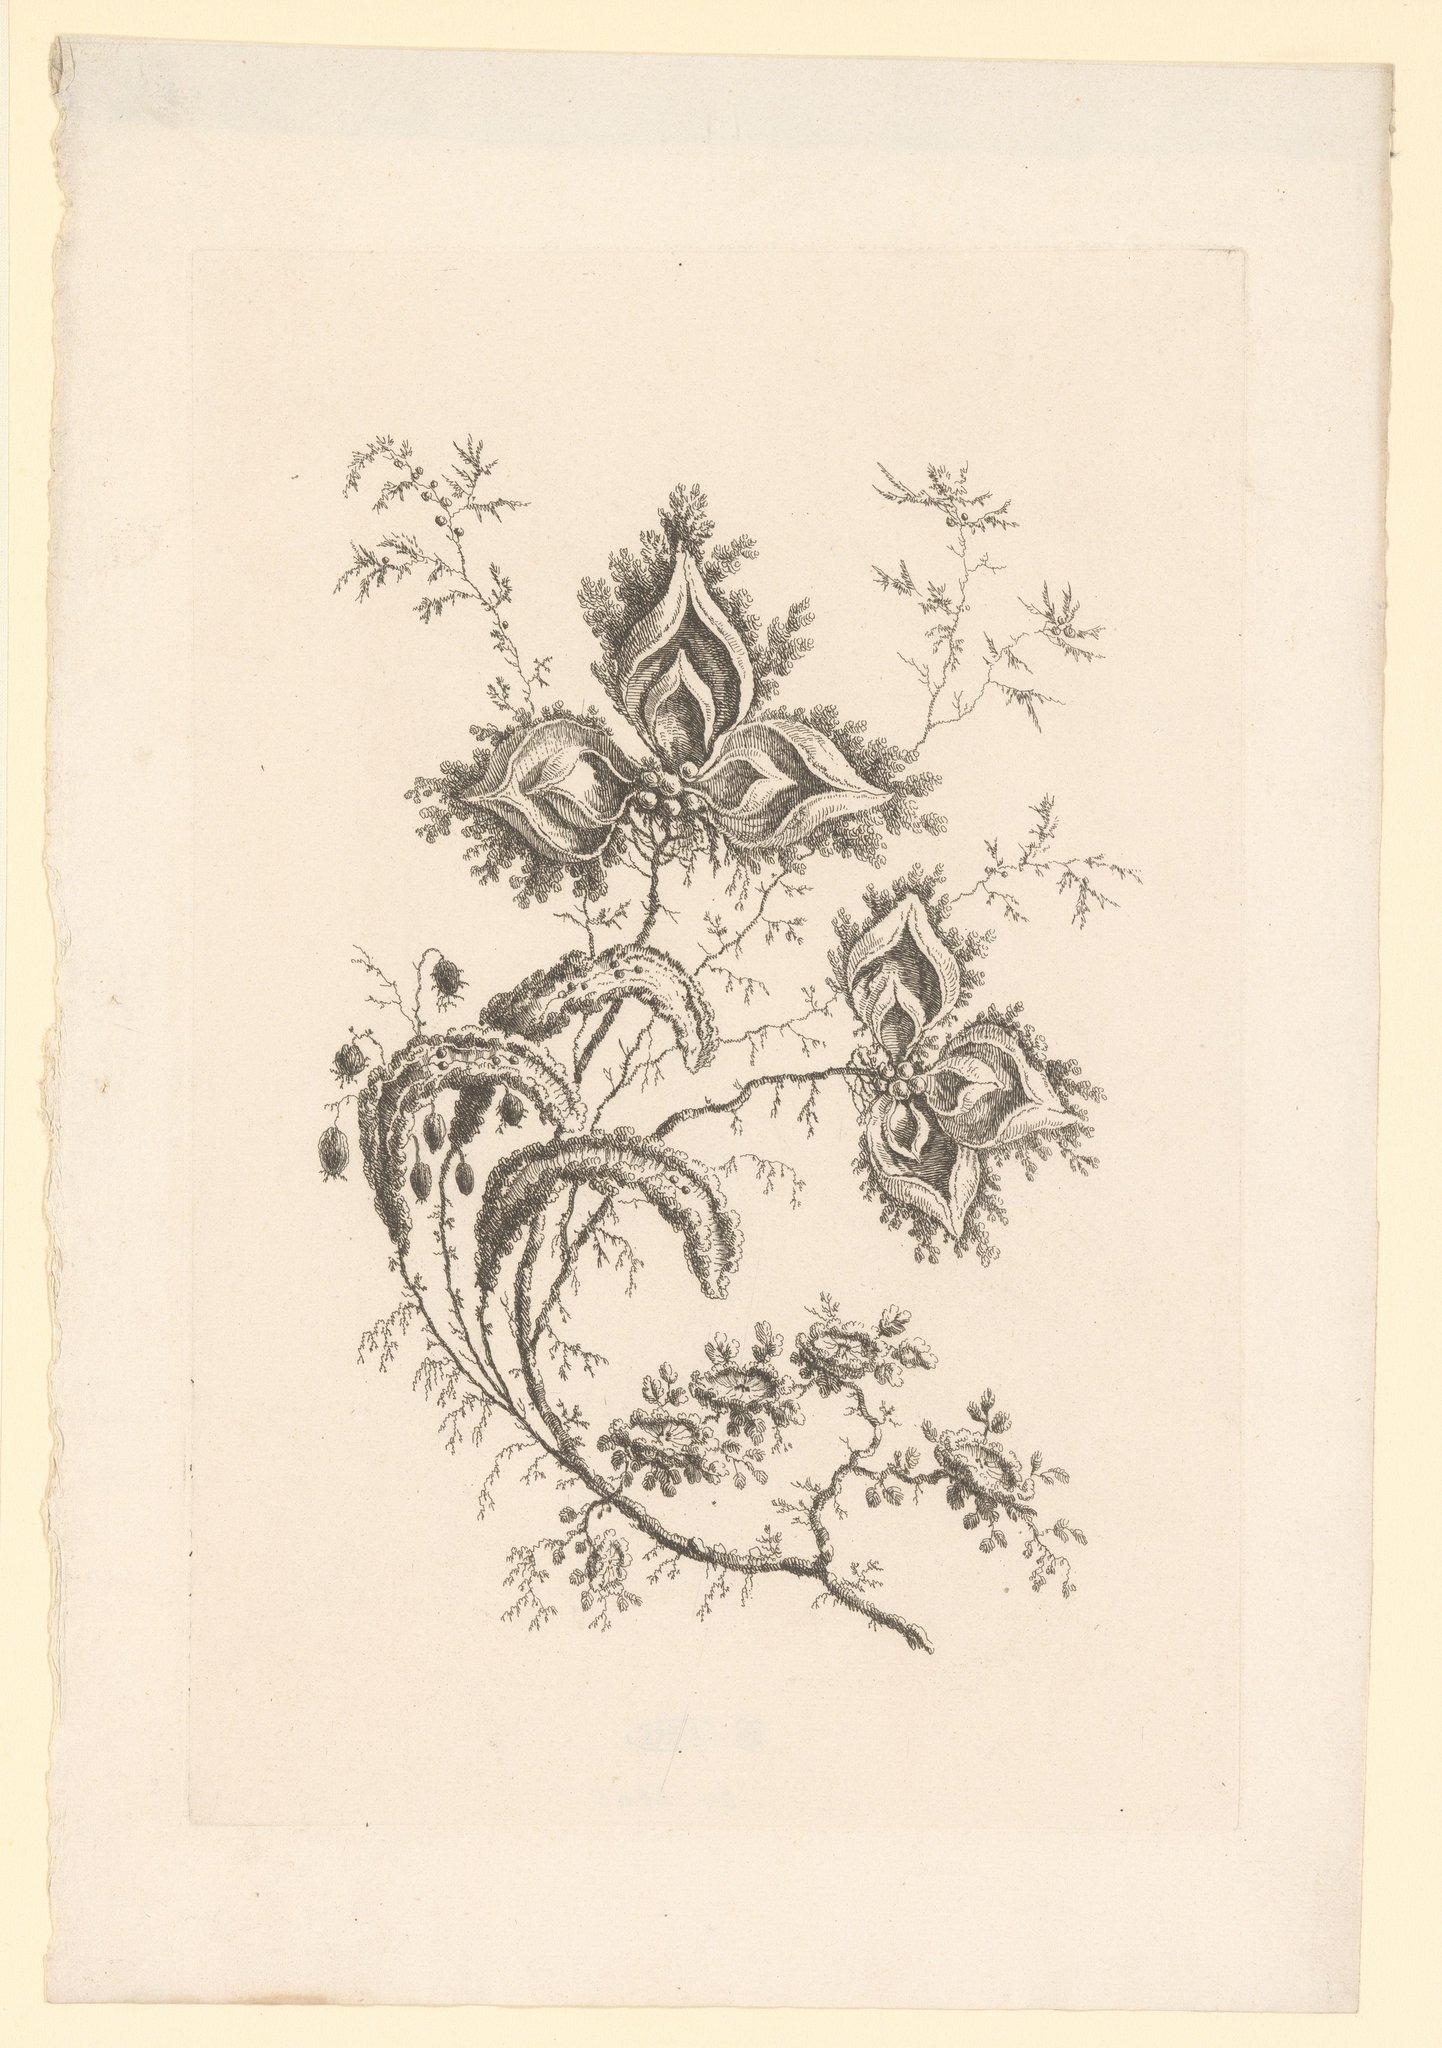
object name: ornament print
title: Fleures Persannes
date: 1767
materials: paper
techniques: etching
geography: paris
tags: flowers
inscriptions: collector's mark: Lugt 2228, collector's mark: Lugt 2760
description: Bloemen bestaand uit drie puntige bladeren.